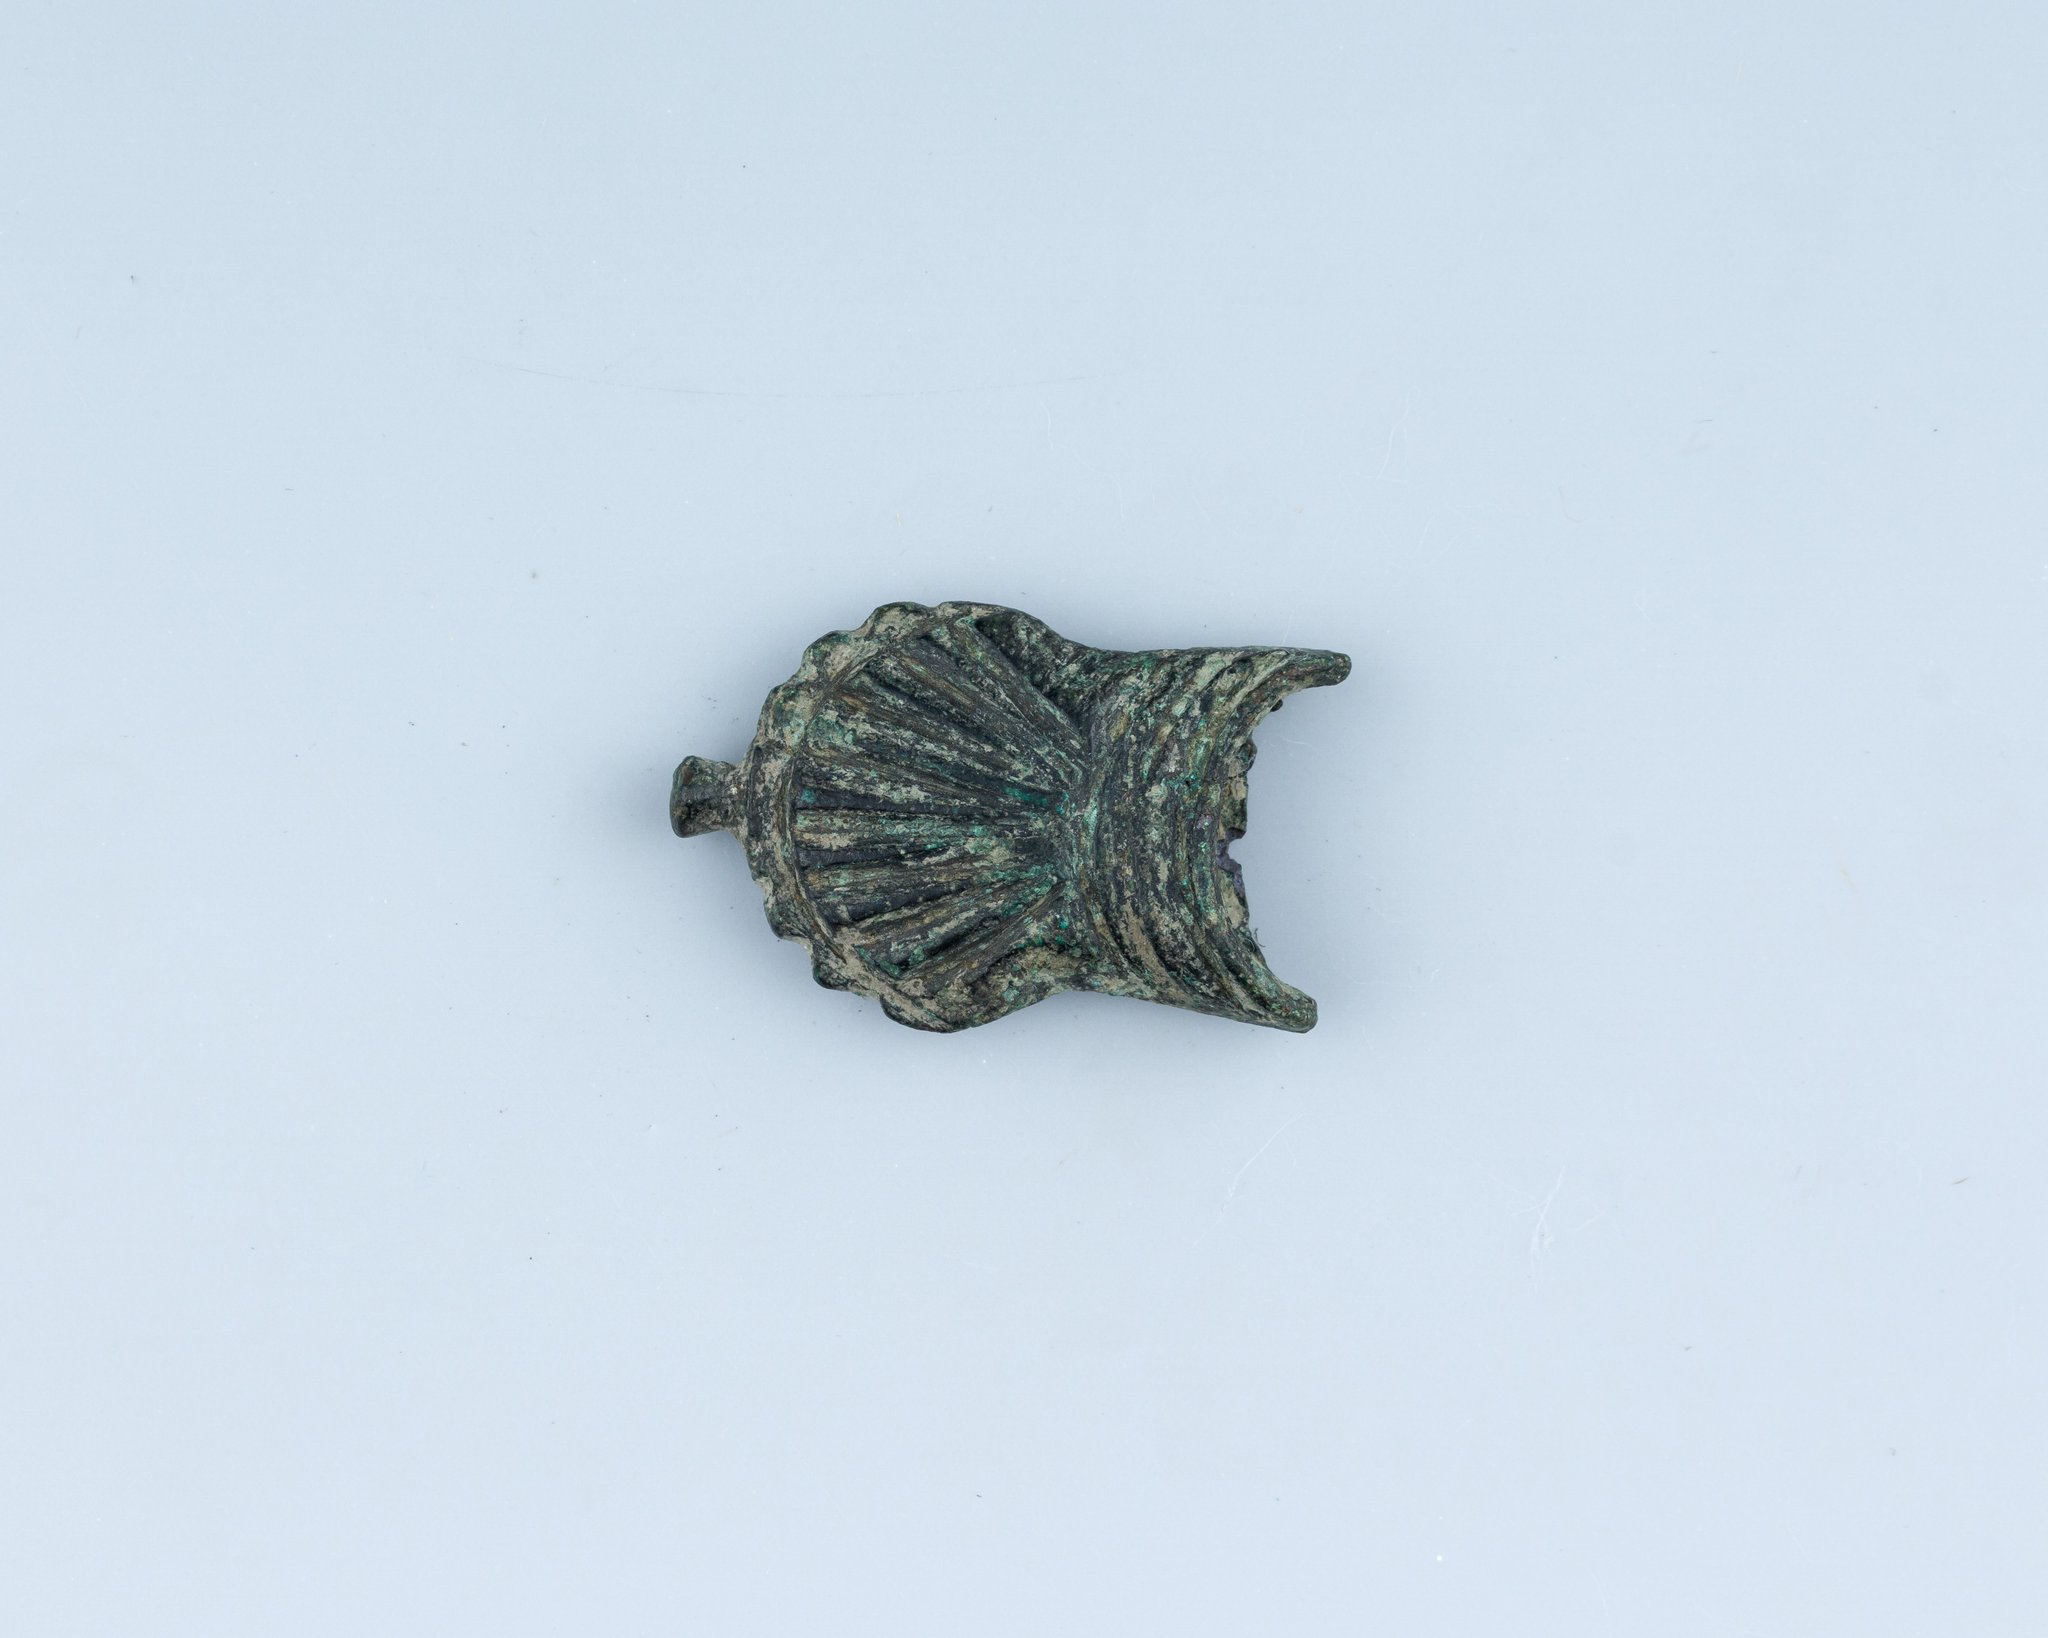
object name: mordant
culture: european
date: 1401-1700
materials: bronze